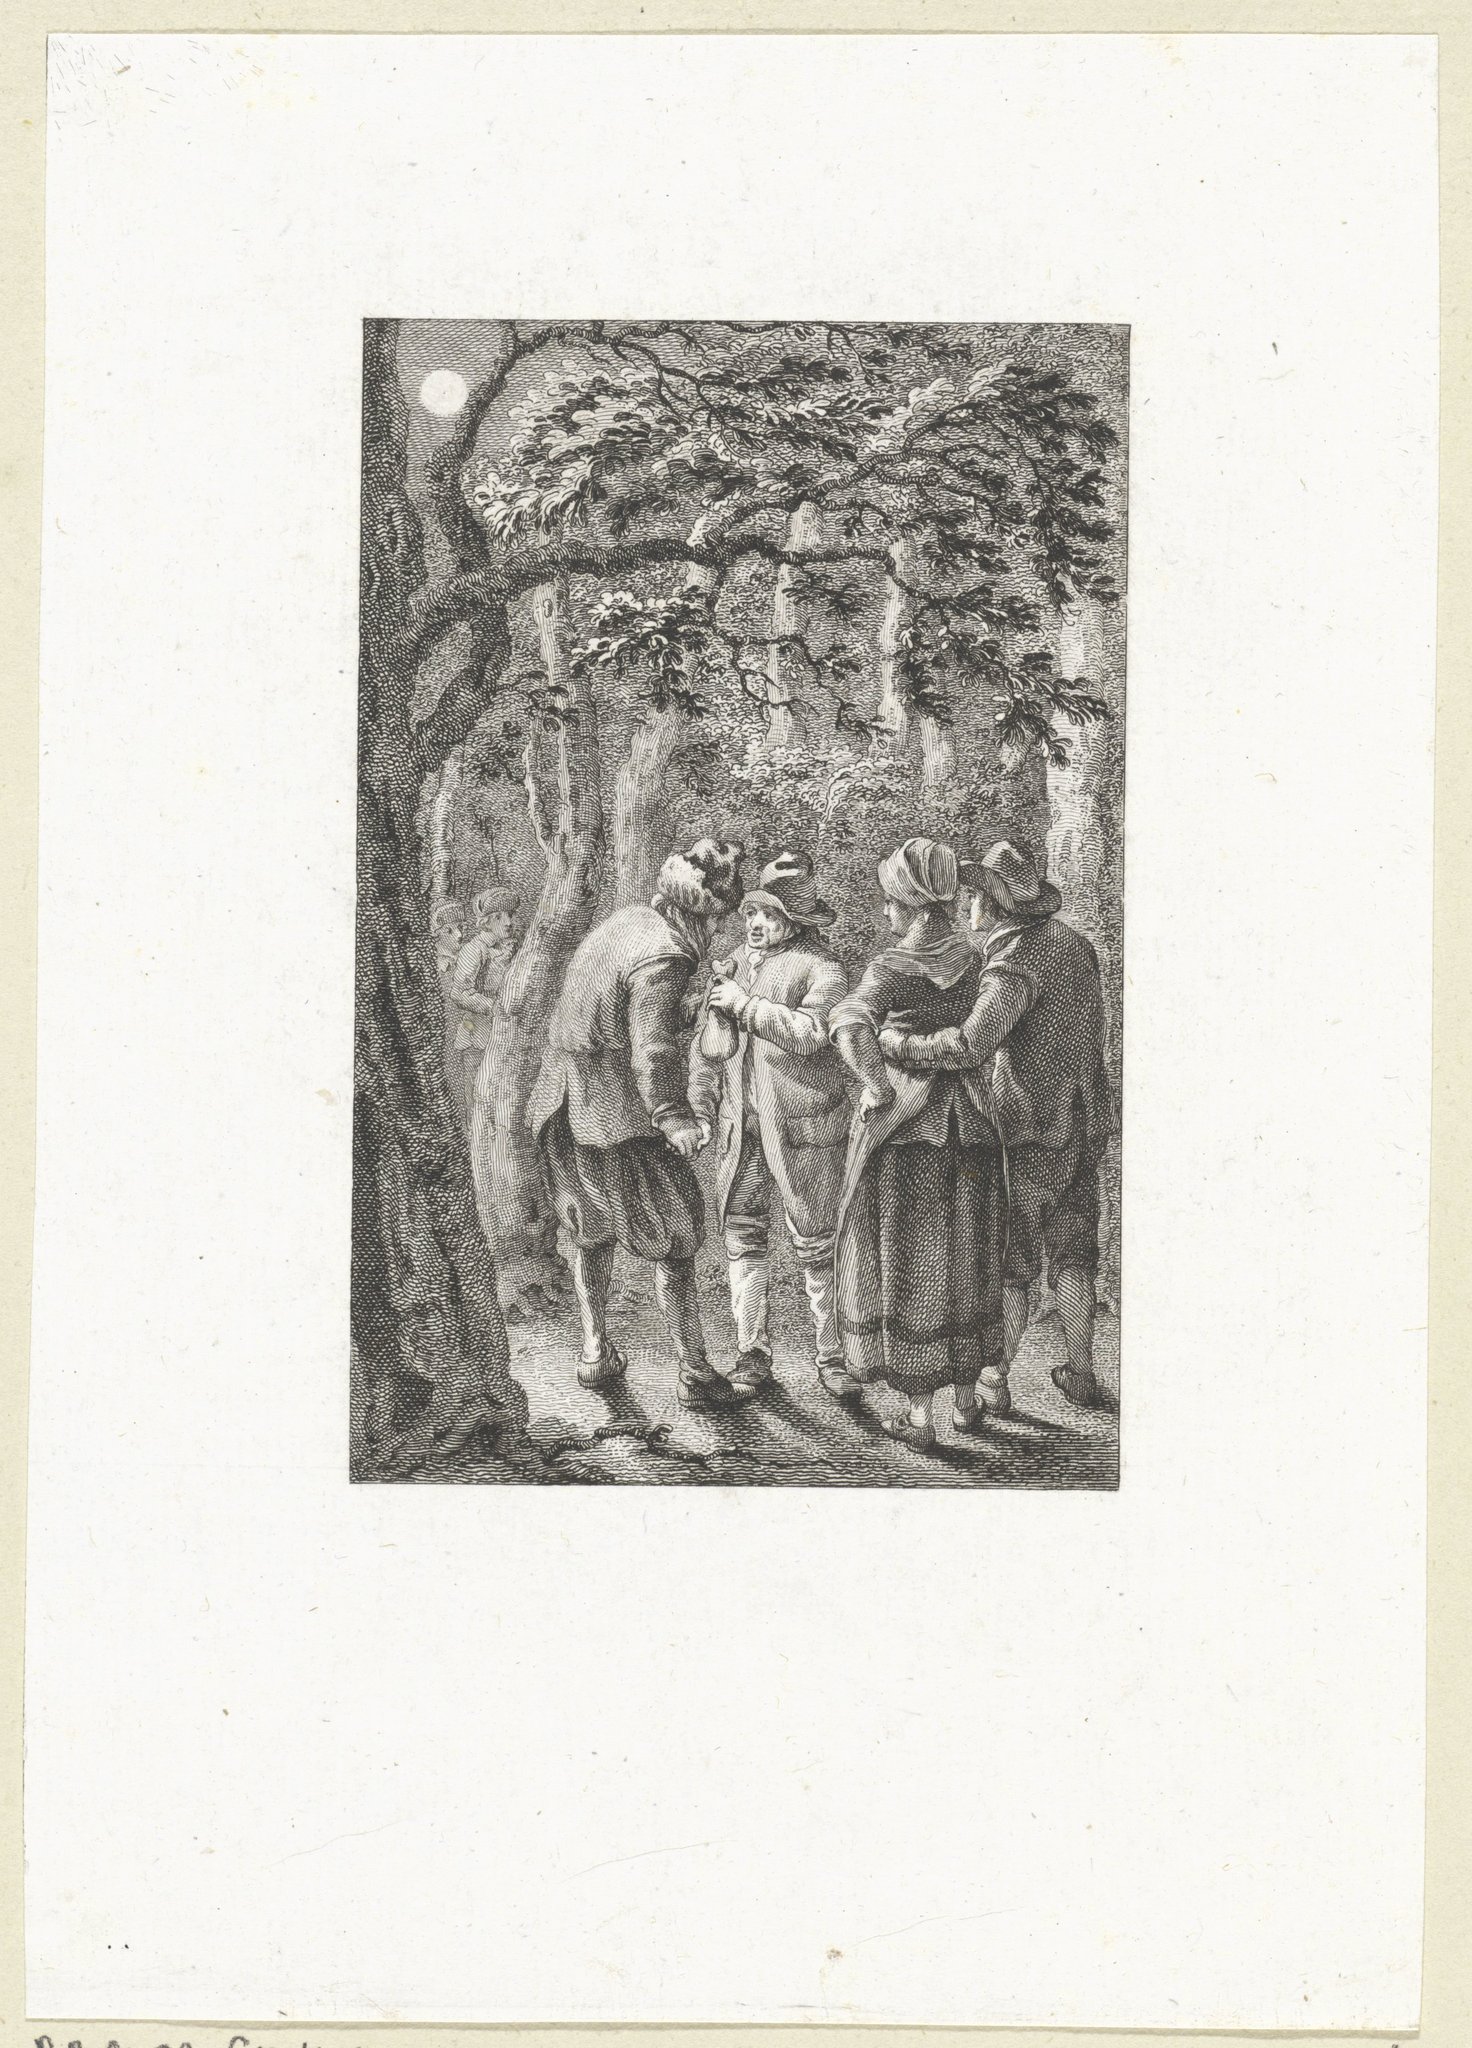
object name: print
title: Nachtgezicht met figuren met een geldzak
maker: reinier vinkeles (i)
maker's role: draughtsman, print maker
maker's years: 1741-1816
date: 1794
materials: paper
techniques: engraving, etching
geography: amsterdam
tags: purse, money-bag, forest, wood, bringing gifts; exchanging gifts, night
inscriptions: collector's mark: Lugt 240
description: In een bos bij nacht wisselen twee mannen een geldzak en iets anders met elkaar uit, onder het toeziend oog van een paar. Op de achtergrond staan twee mannen naar het tafereel te kijken, verborgen achter het geboomte.